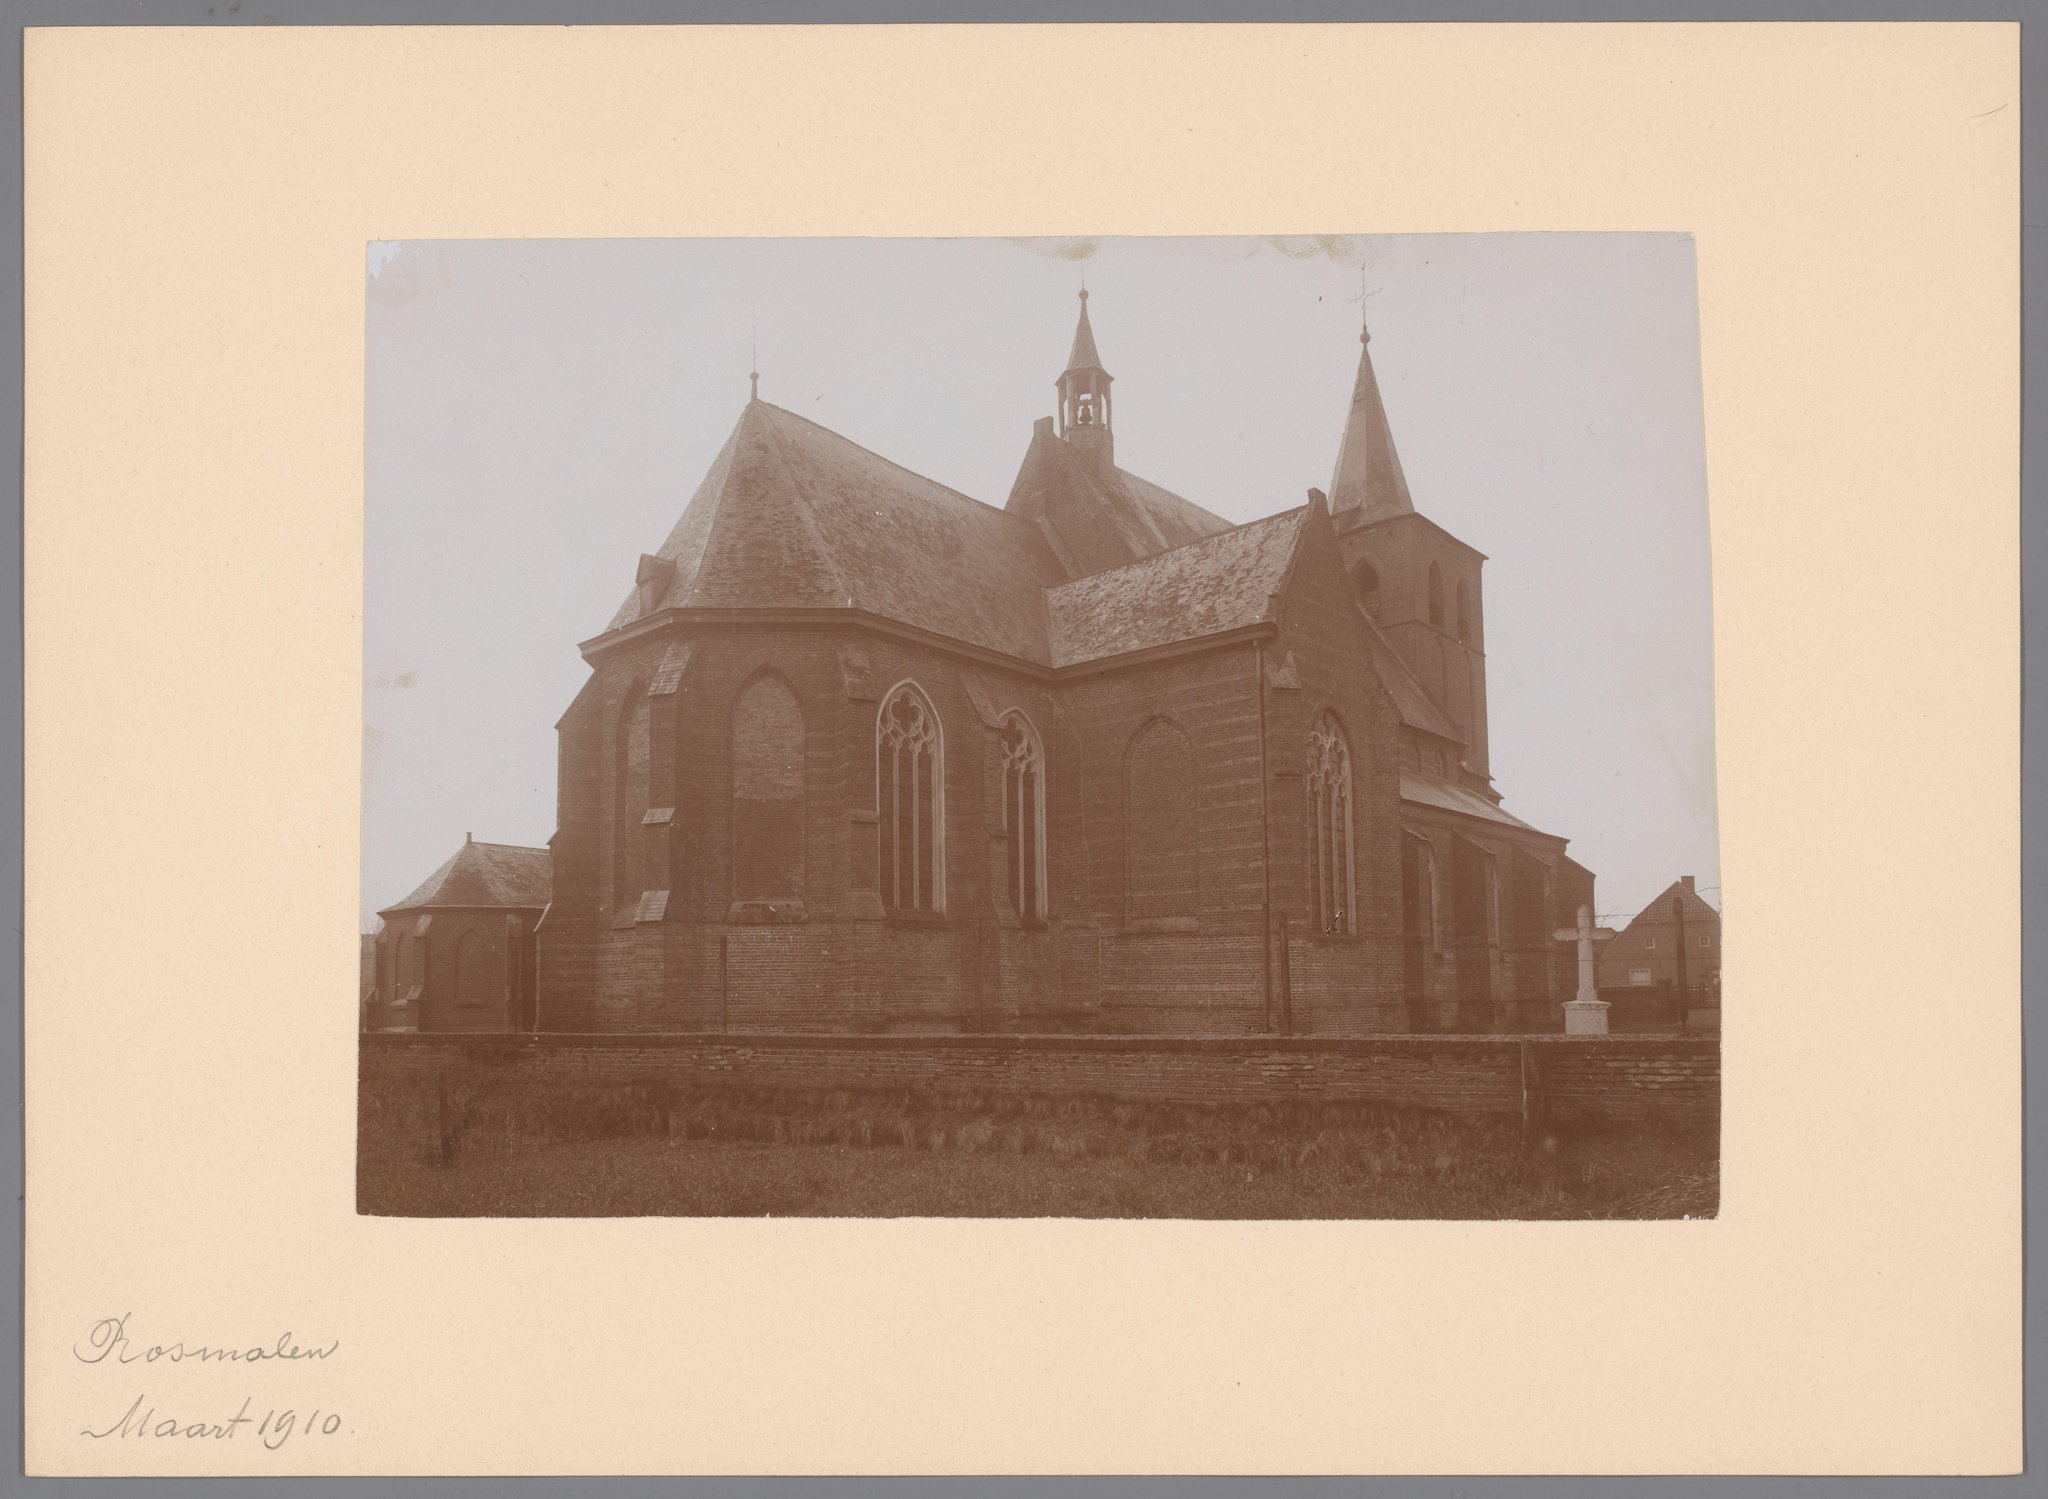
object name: photograph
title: Noordoostzijde van de Sint-Lambertuskerk te Rosmalen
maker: anoniem (monumentenzorg)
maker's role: fotograaf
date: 1910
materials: cardboard, photographic support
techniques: collodion silver print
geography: rosmalen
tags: church (exterior), rosmalen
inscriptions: annotation: ‘Rosmalen/ Maart 1910’